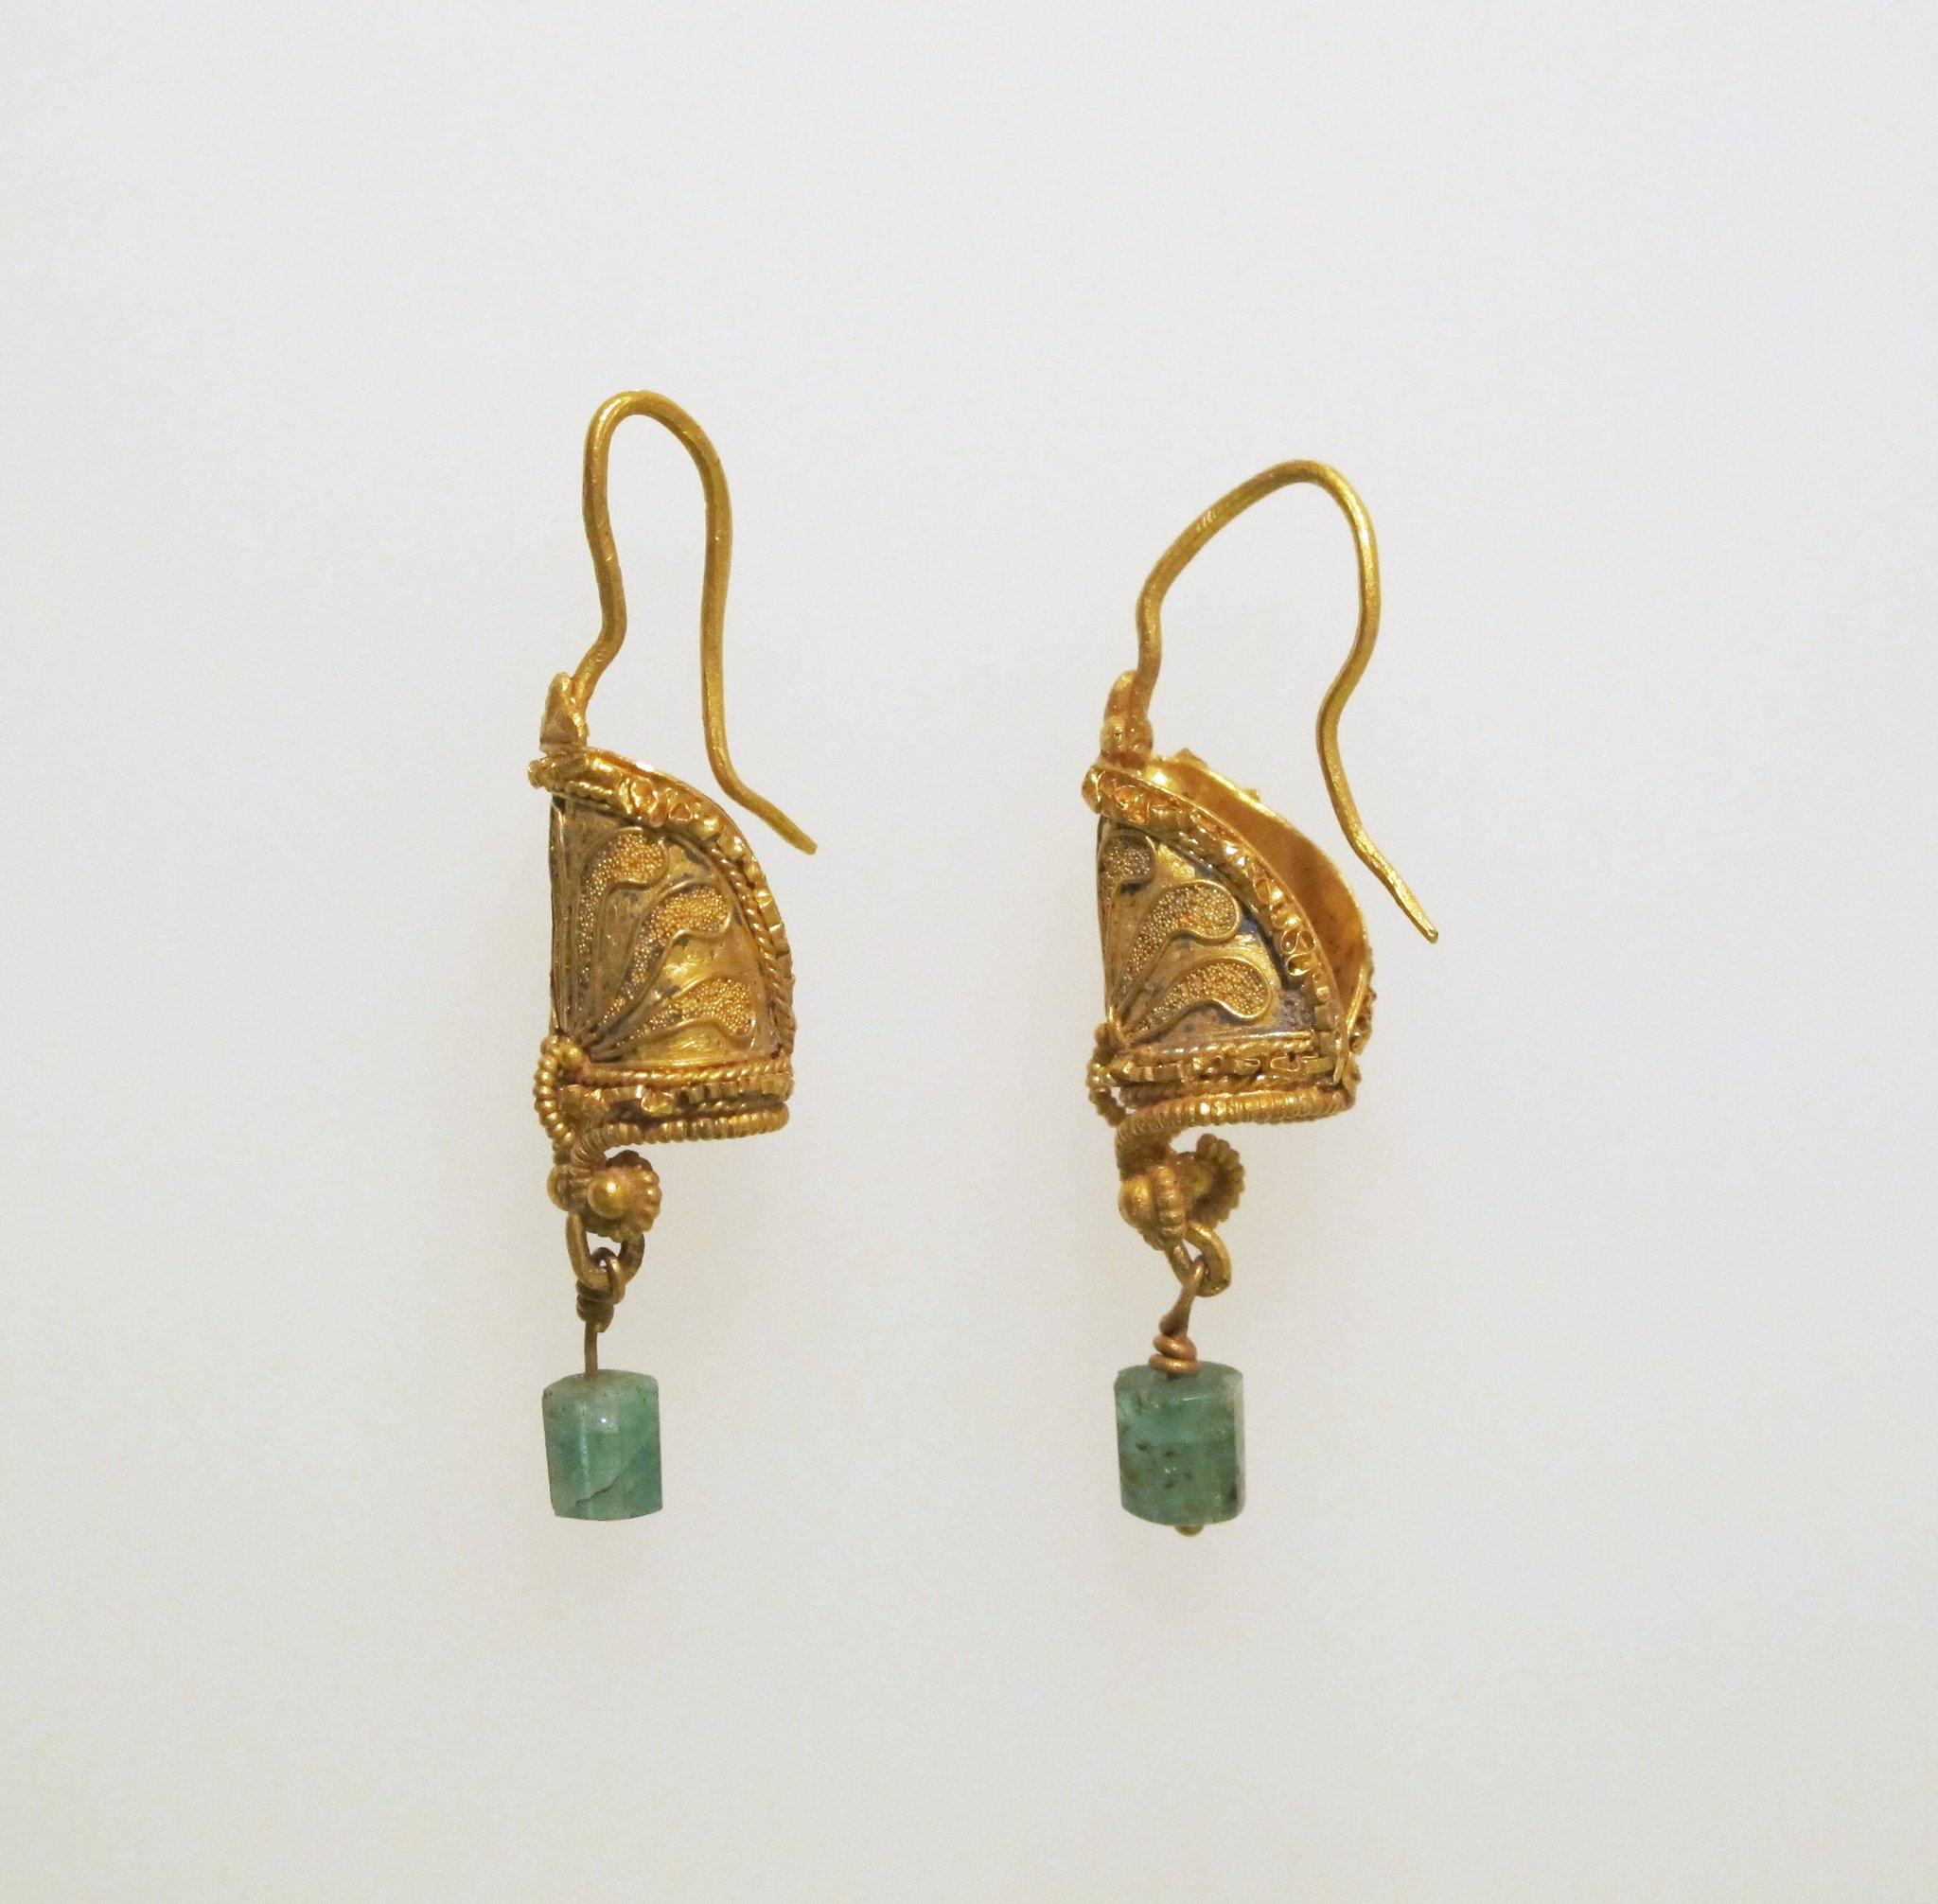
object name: earring in the form of a shield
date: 7000 BCE-330 CE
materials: gold